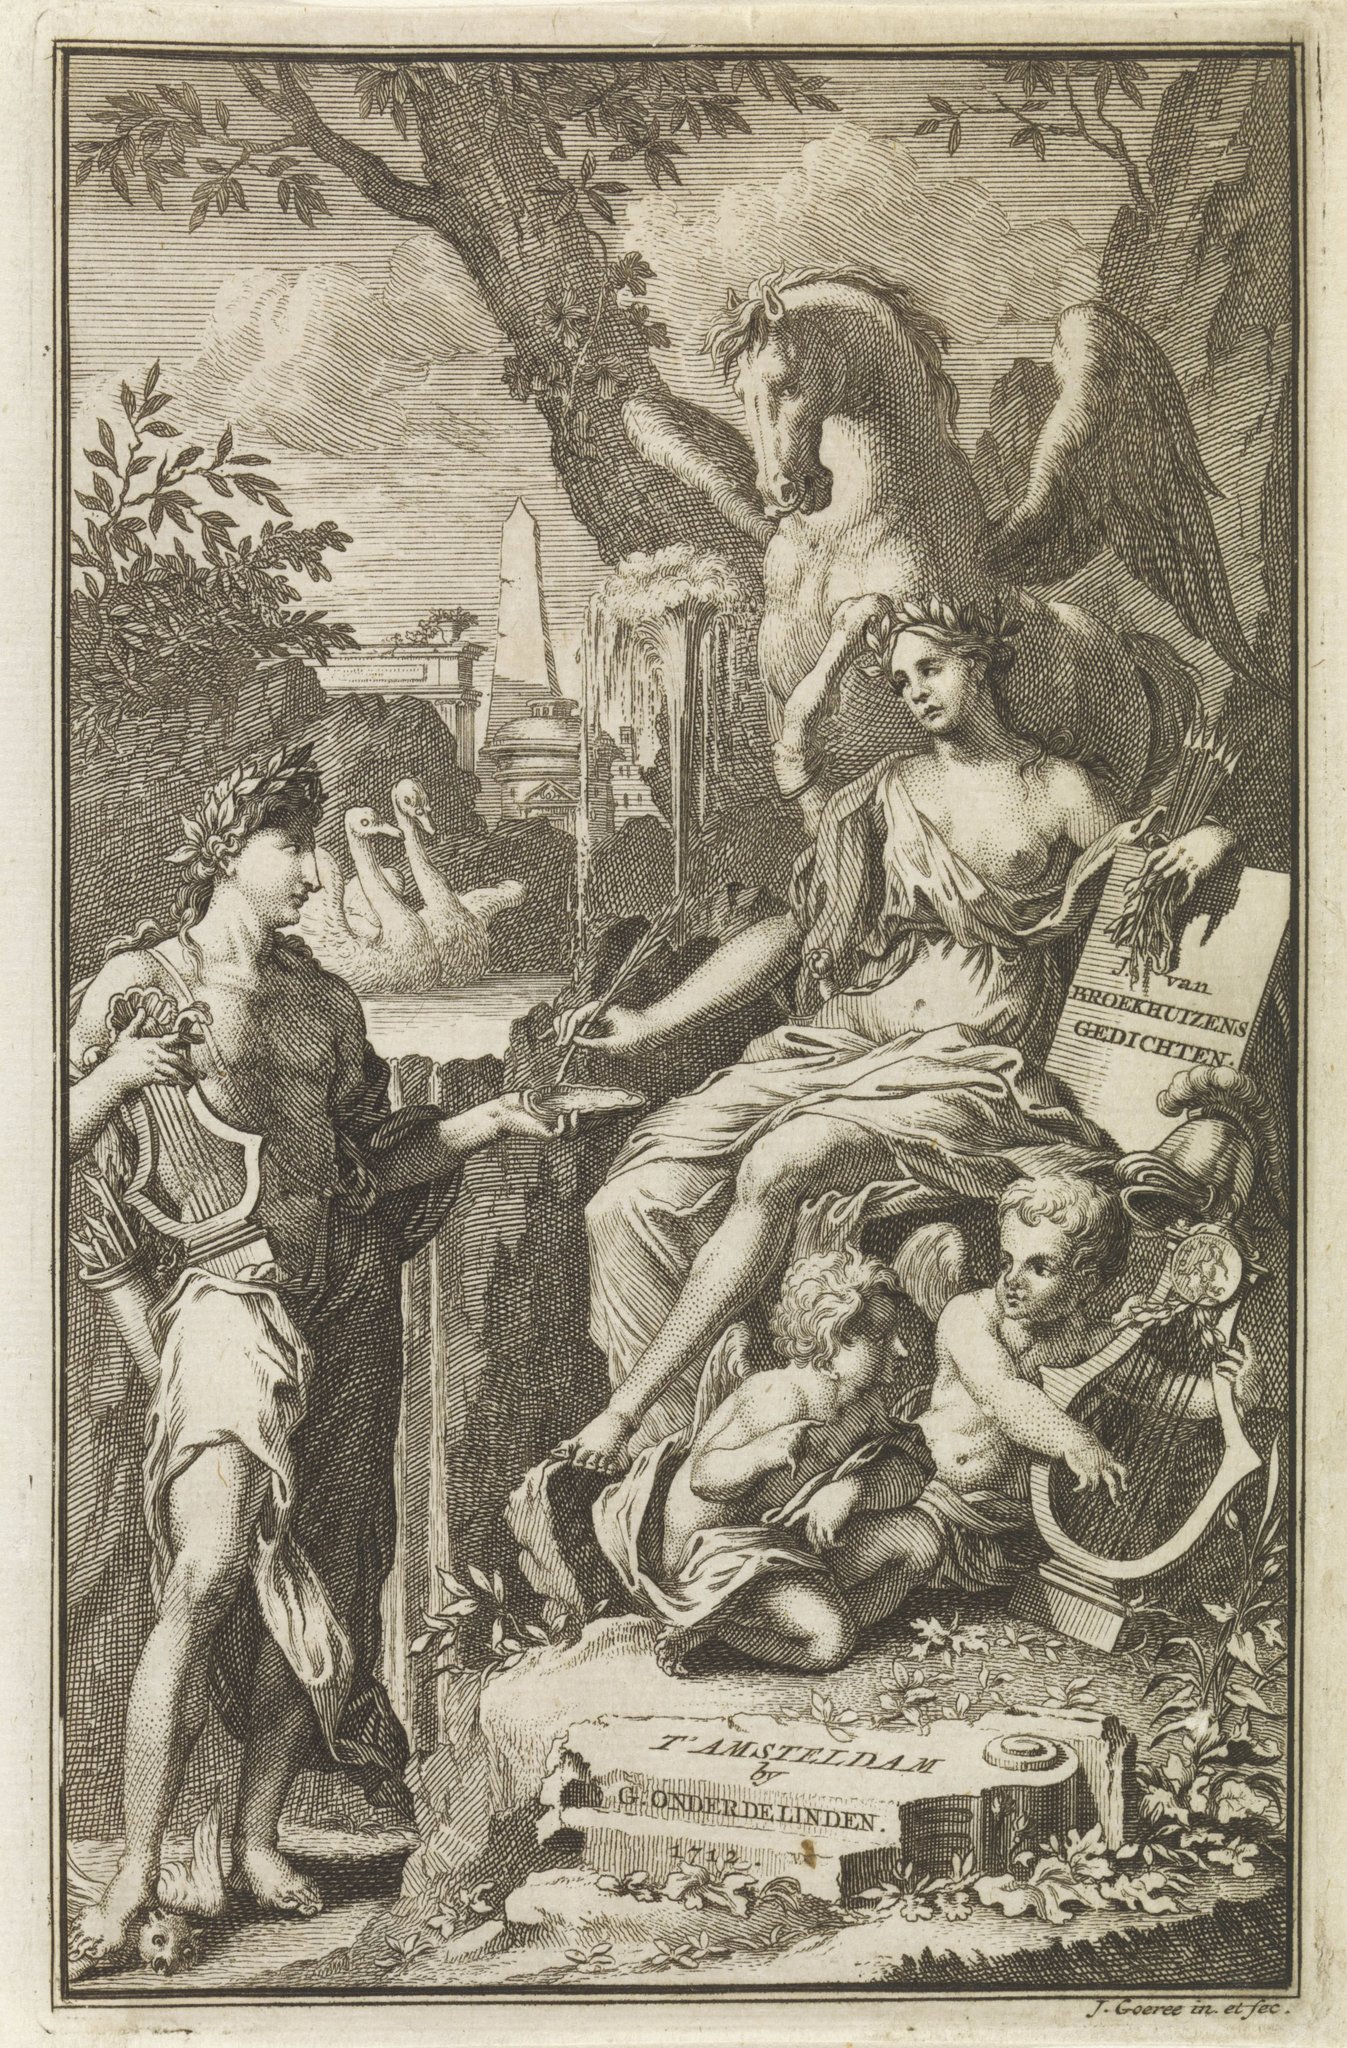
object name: titelblad, titelpagina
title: Venus en Apollo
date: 1712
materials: paper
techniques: engraving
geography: amsterdam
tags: pegasus, the winged horse, (story of) apollo (phoebus), owls, (story of) venus (aphrodite), cupids: 'amores', 'amoretti', 'putti'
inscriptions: date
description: In het midden Venus op een troon. In haar hand een stenen plaat met de titel van het boekwerk. Naast haar troon twee putti met een lier. Apollo staat links en vertrapt een uil onder zijn rechtervoet. Venus schrijft met een veer in een boek dat Apollo haar aanreikt. Achter de troon een pegasus.